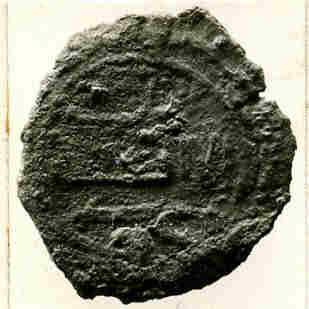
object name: coin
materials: copper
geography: iran